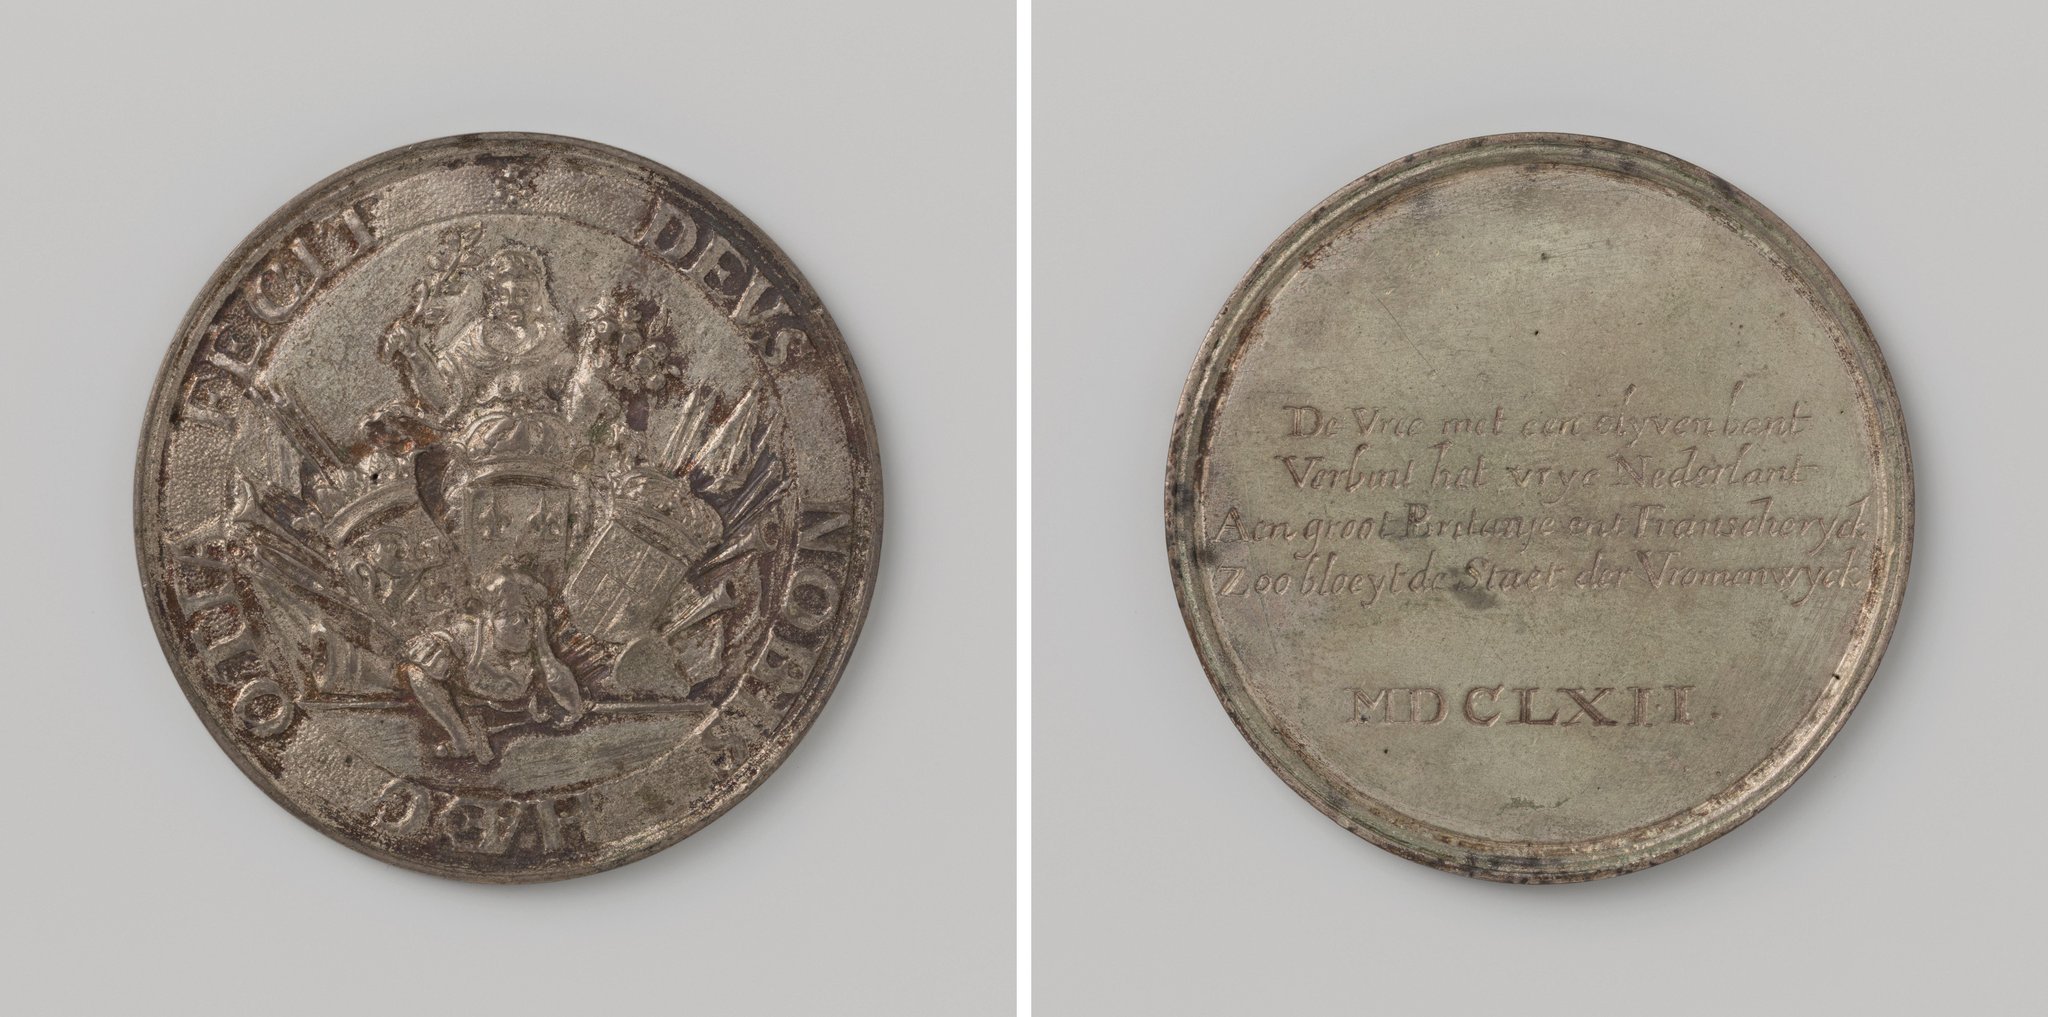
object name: copy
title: Verdrag tussen Engeland, Frankrijk en de Verenigde Nederlanden, gesloten te Parijs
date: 1662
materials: silver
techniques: engraving, striking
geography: amsterdam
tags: france, paris, low countries, england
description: Zilveren penning. Voorzijde: Vrede met olijftak en hoorn van overvloed staande op stapel oorlogstuig, daarvoor drie gekroonde wapenschilden en liggende Mars binnen omschrift. Keerzijde: opschrift.